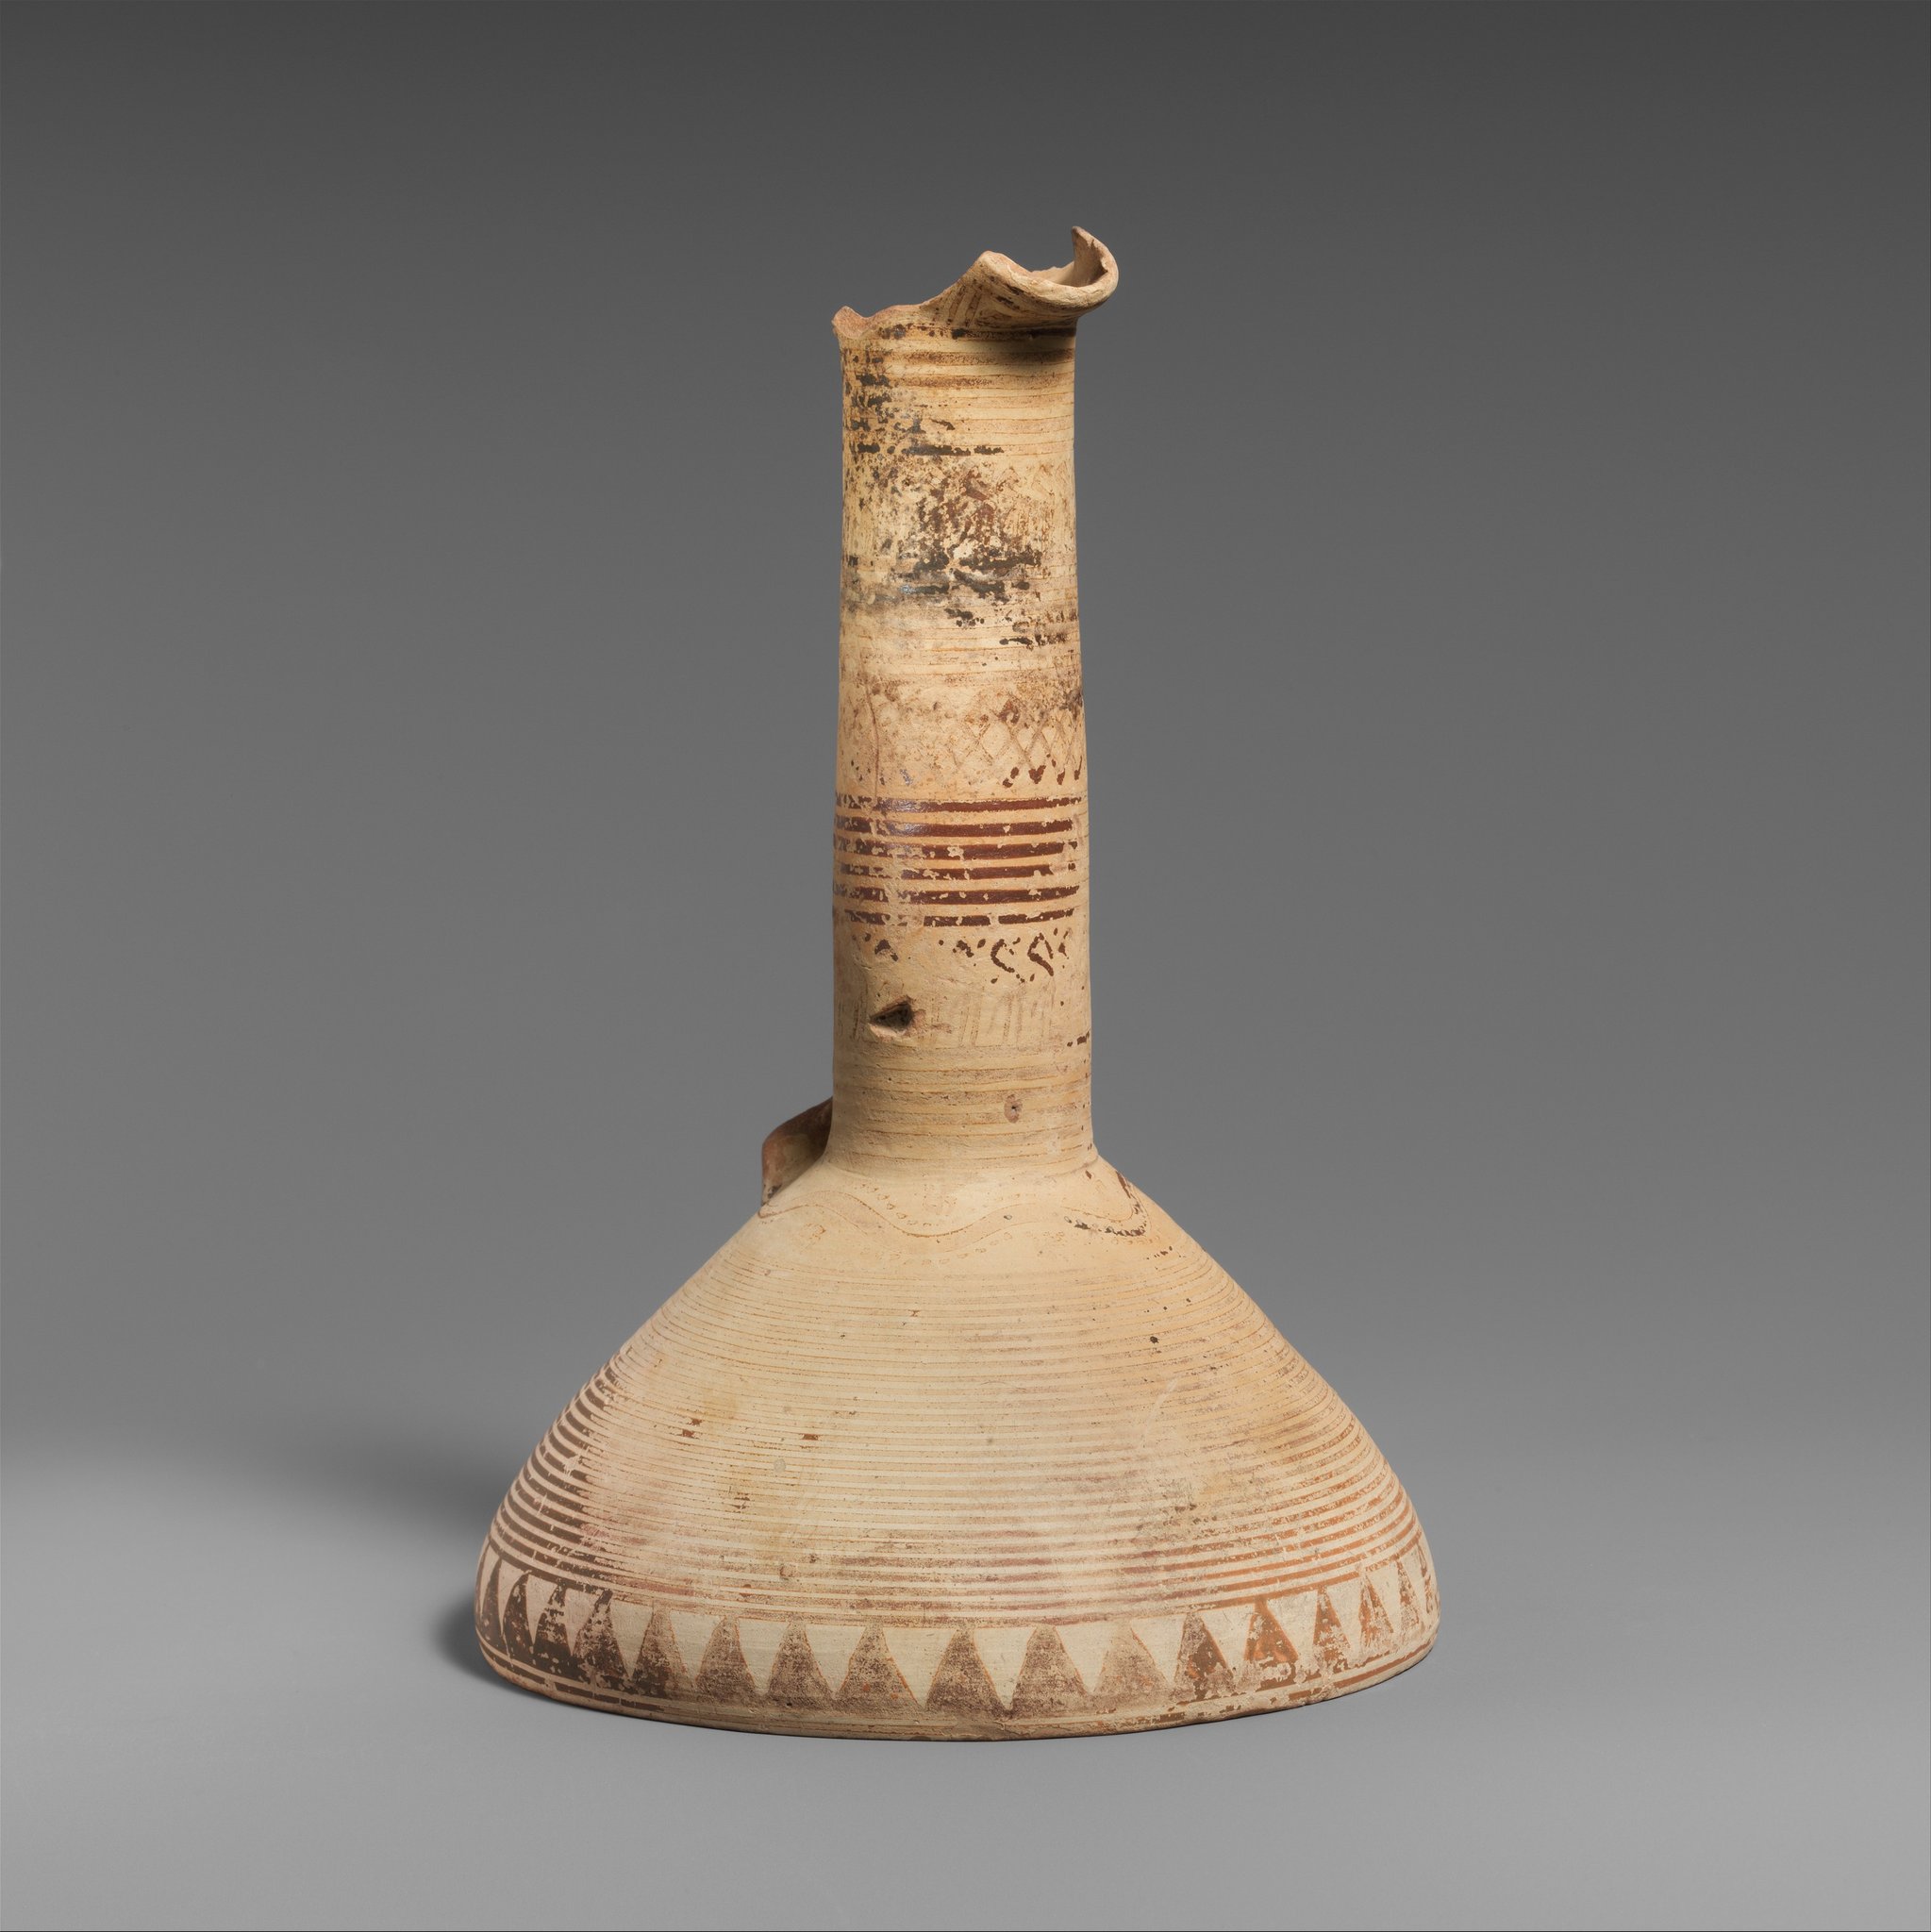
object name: oinochoe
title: Terracotta oinochoe (jug)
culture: greek, corinthian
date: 725-690 BCE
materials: terracotta